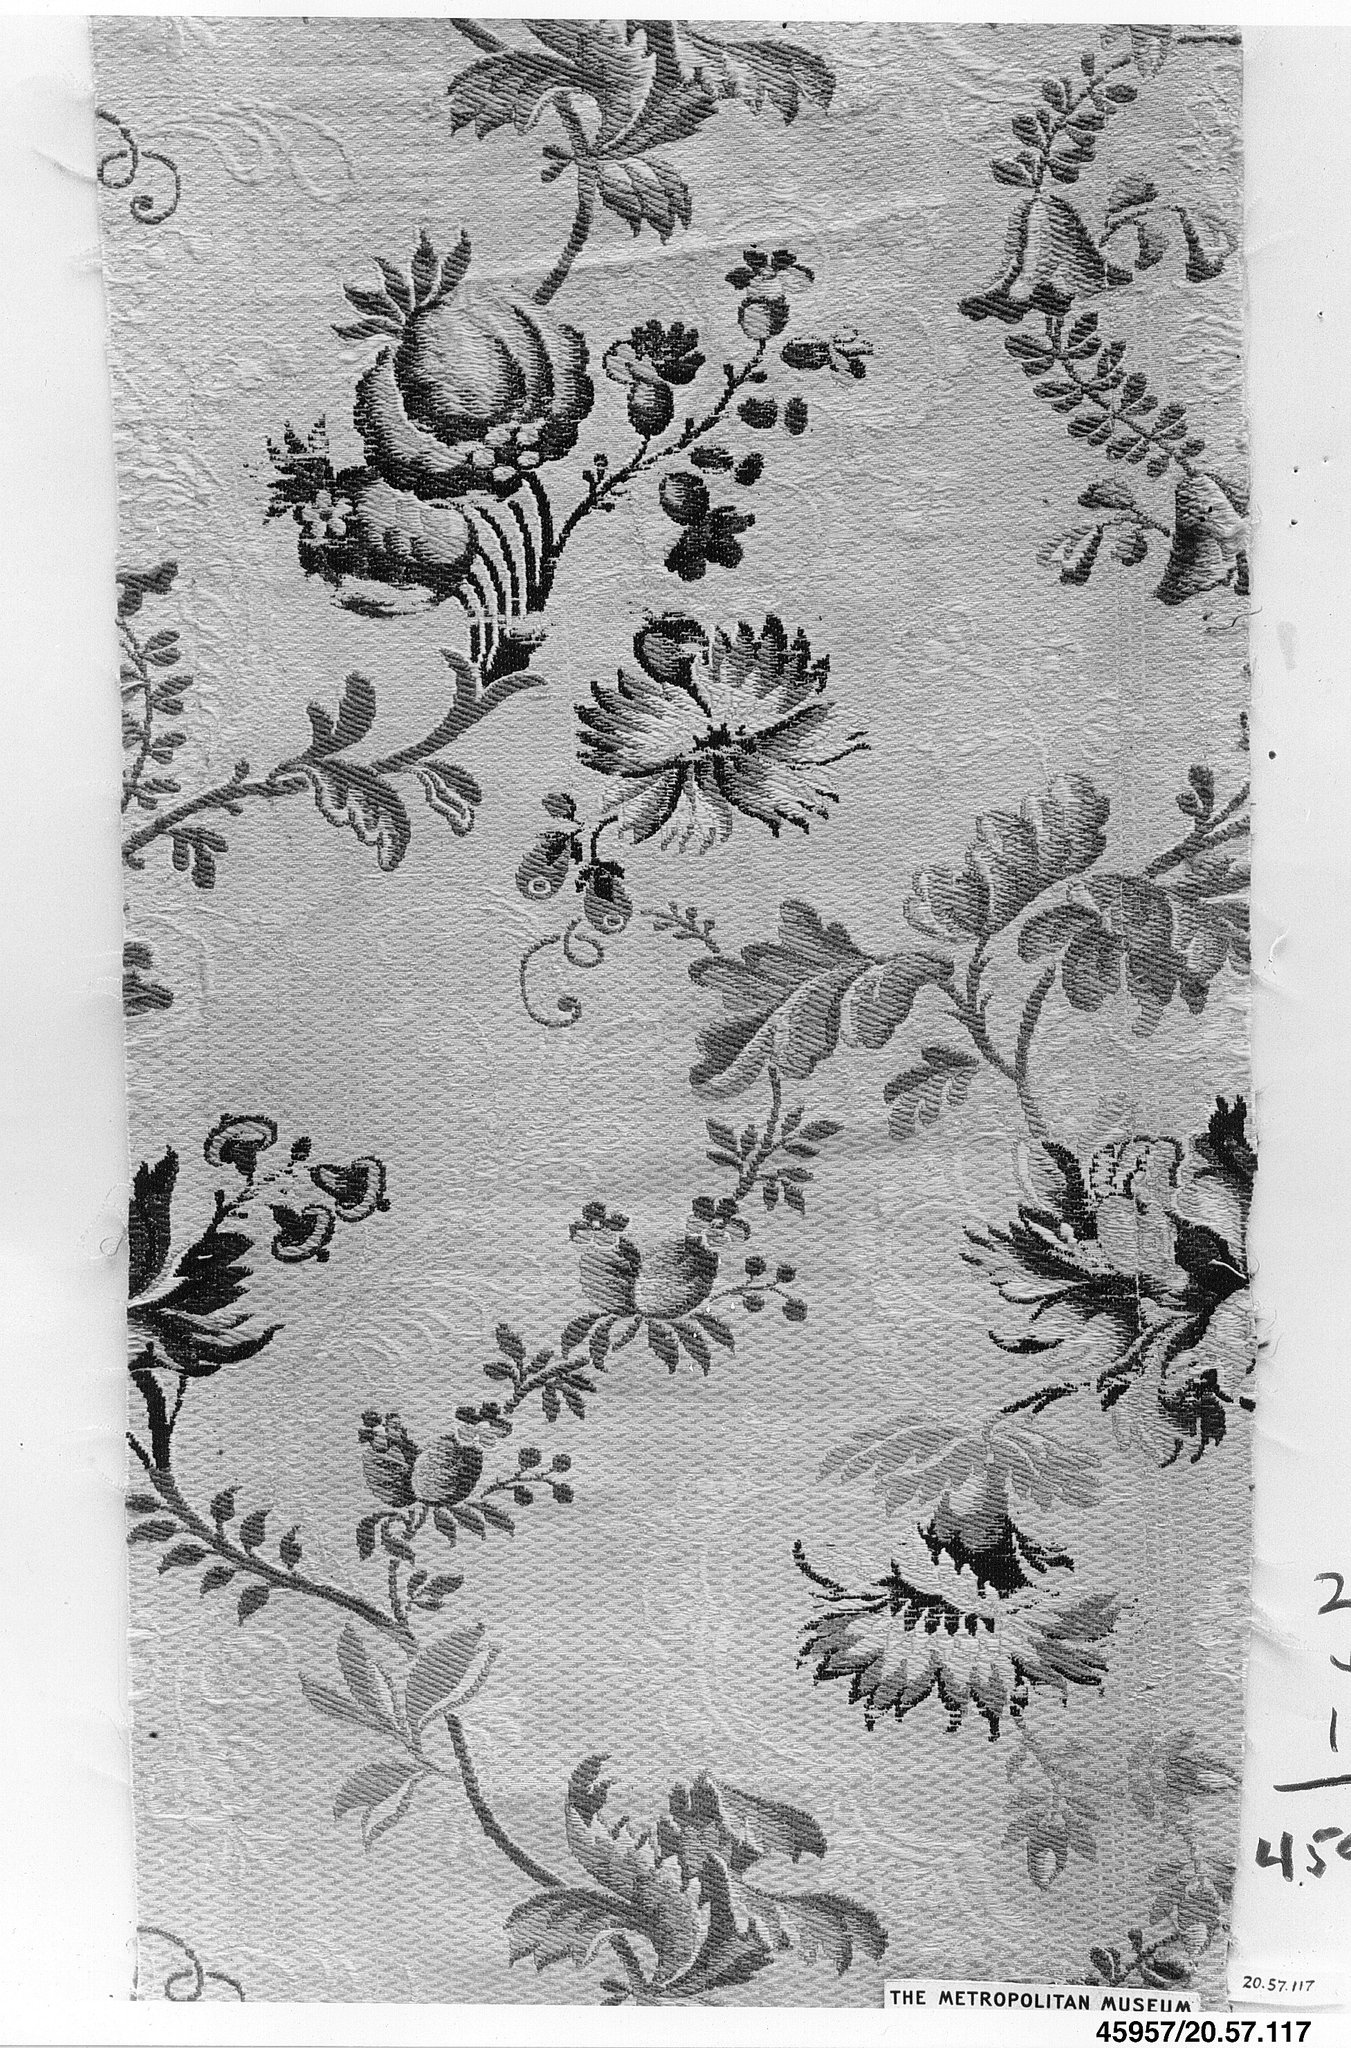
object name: piece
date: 1750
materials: silk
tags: flowers,leaves